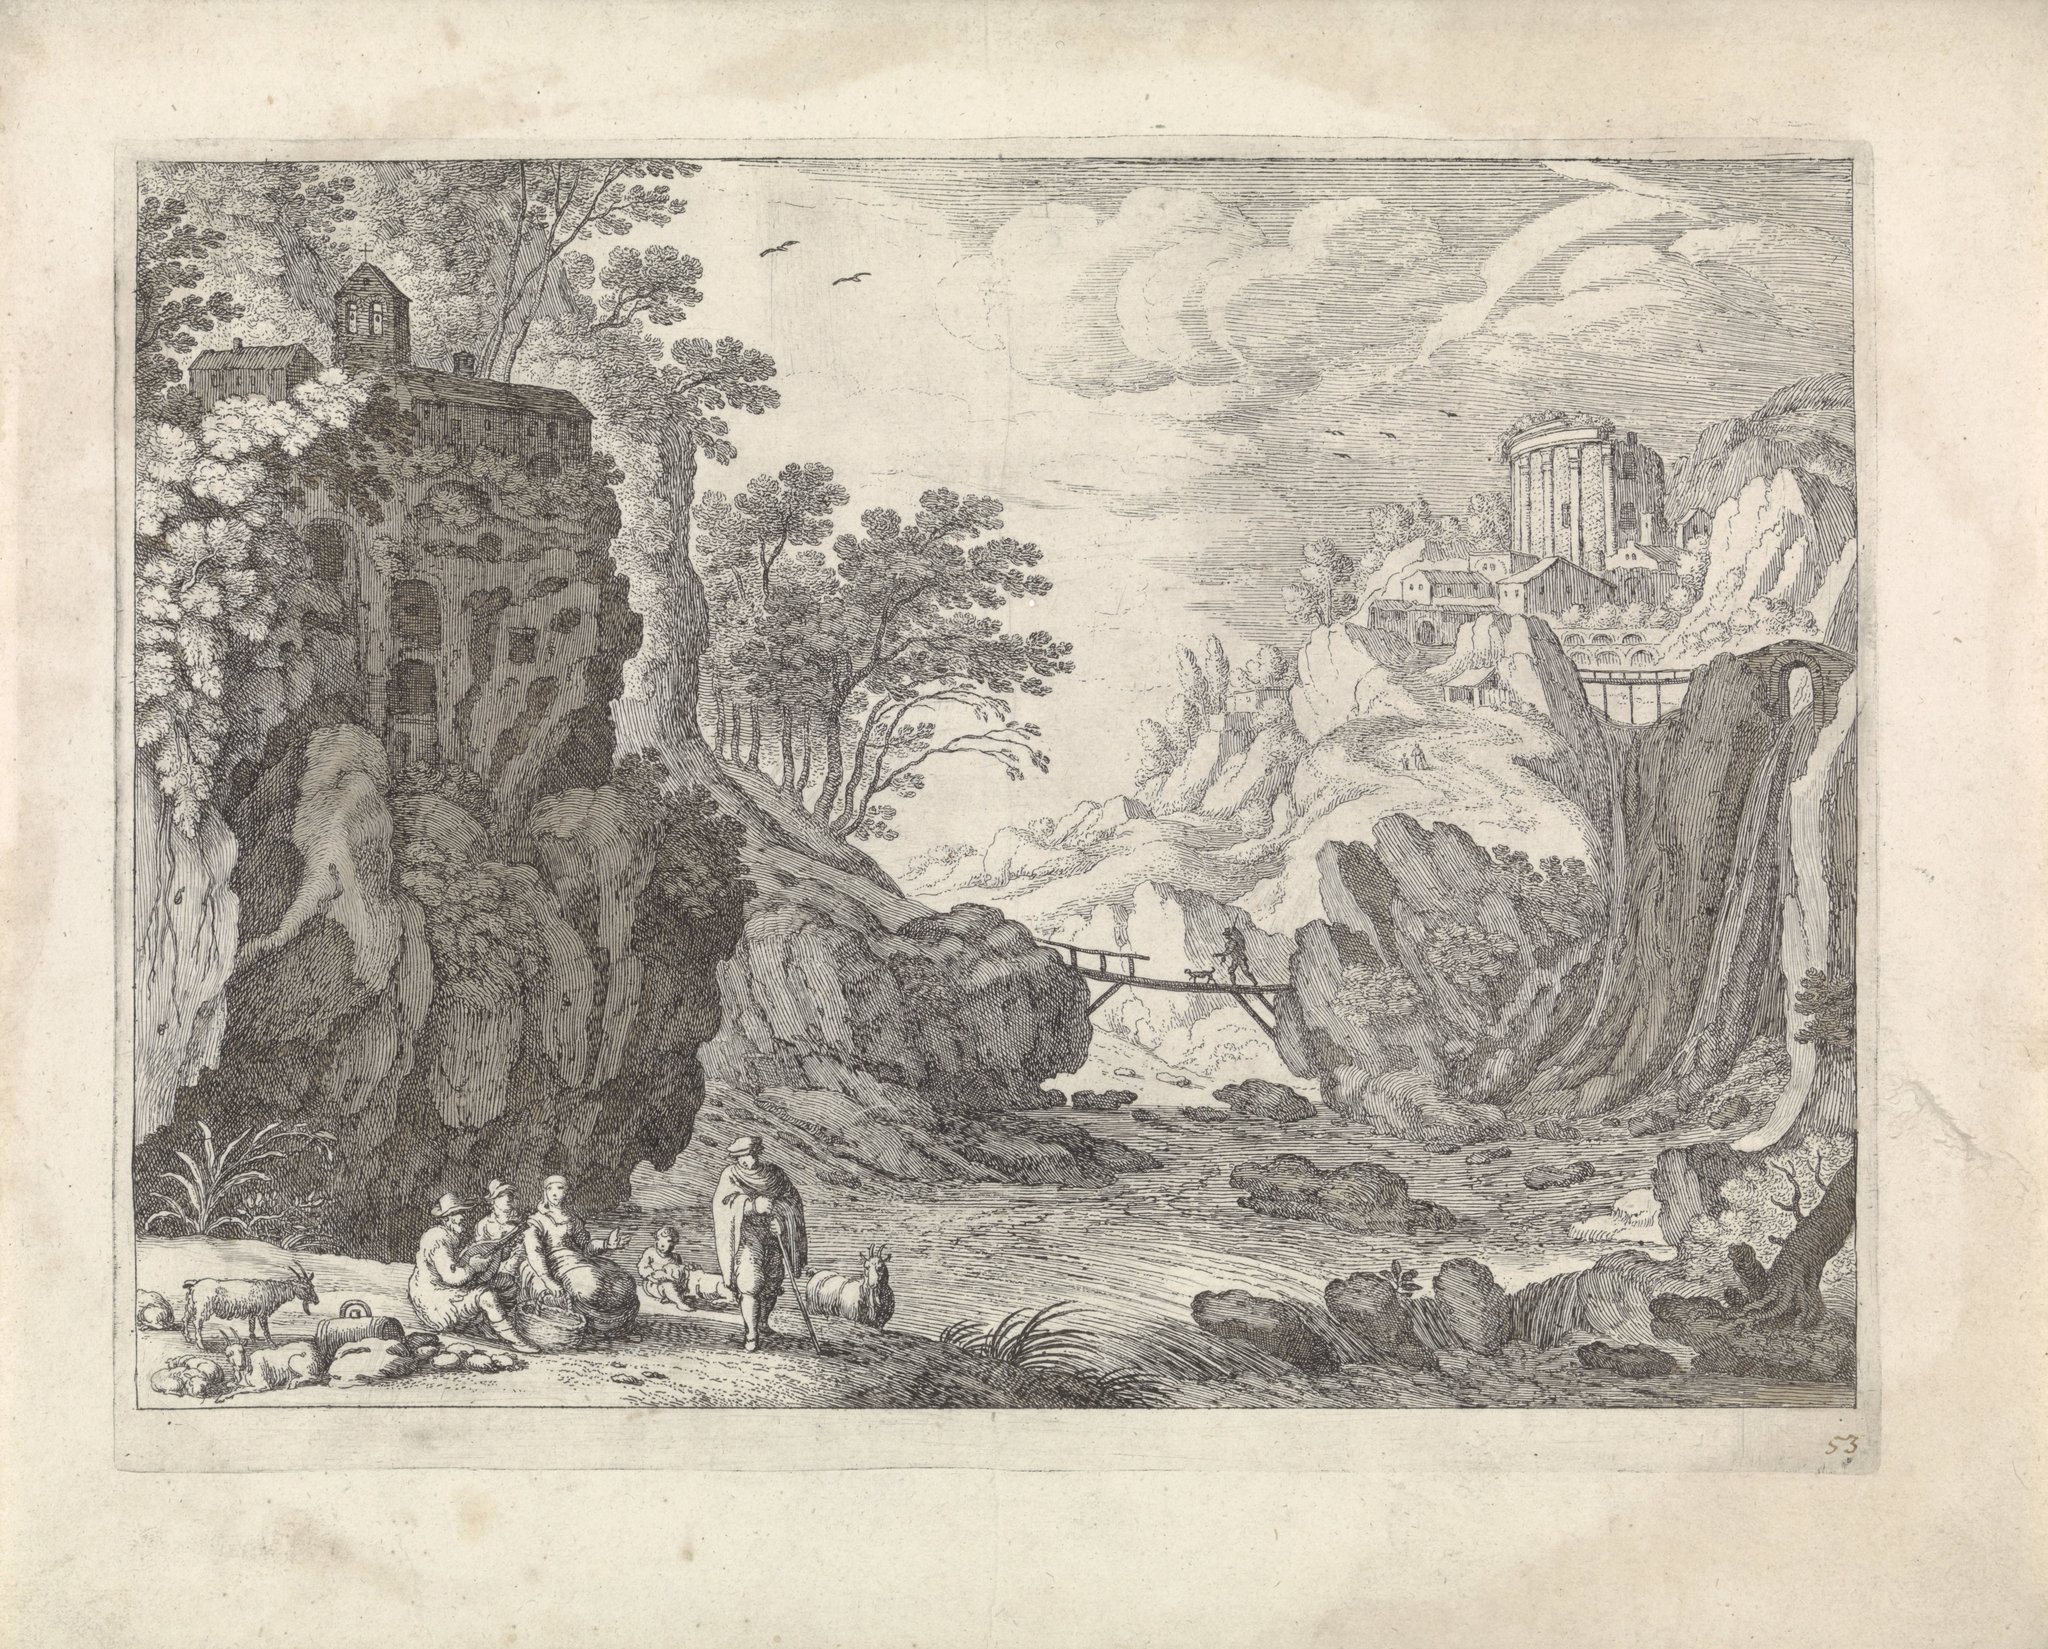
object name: print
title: Rotslandschap met een rivier en een groep figuren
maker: guilliam van nieulandt (ii)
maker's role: draughtsman, print maker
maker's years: 1584-1635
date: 1594-1635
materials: paper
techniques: brush, engraving, etching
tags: river, herding, herdsman, herdswoman, shepherd, shepherdess, cowherd, etc., ruin of a building ~ architecture, church (exterior) - qq - small church, chapel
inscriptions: collector's mark: Lugt 2760, collector's mark: Lugt 2228, inscription: ‘53’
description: Op de voorgrond in een rotslandschap zit een groep herders, bestaande uit drie mannen, waarvan één een snaarinstrument bespeelt, een vrouw en een kind. Naast hen een kudde geiten. Een figuur met een hond steekt een houten brug over de rivier over. Links op de rotsen staat een kapel, links op de rotsen staat een ruïne van een klassieke tempel.